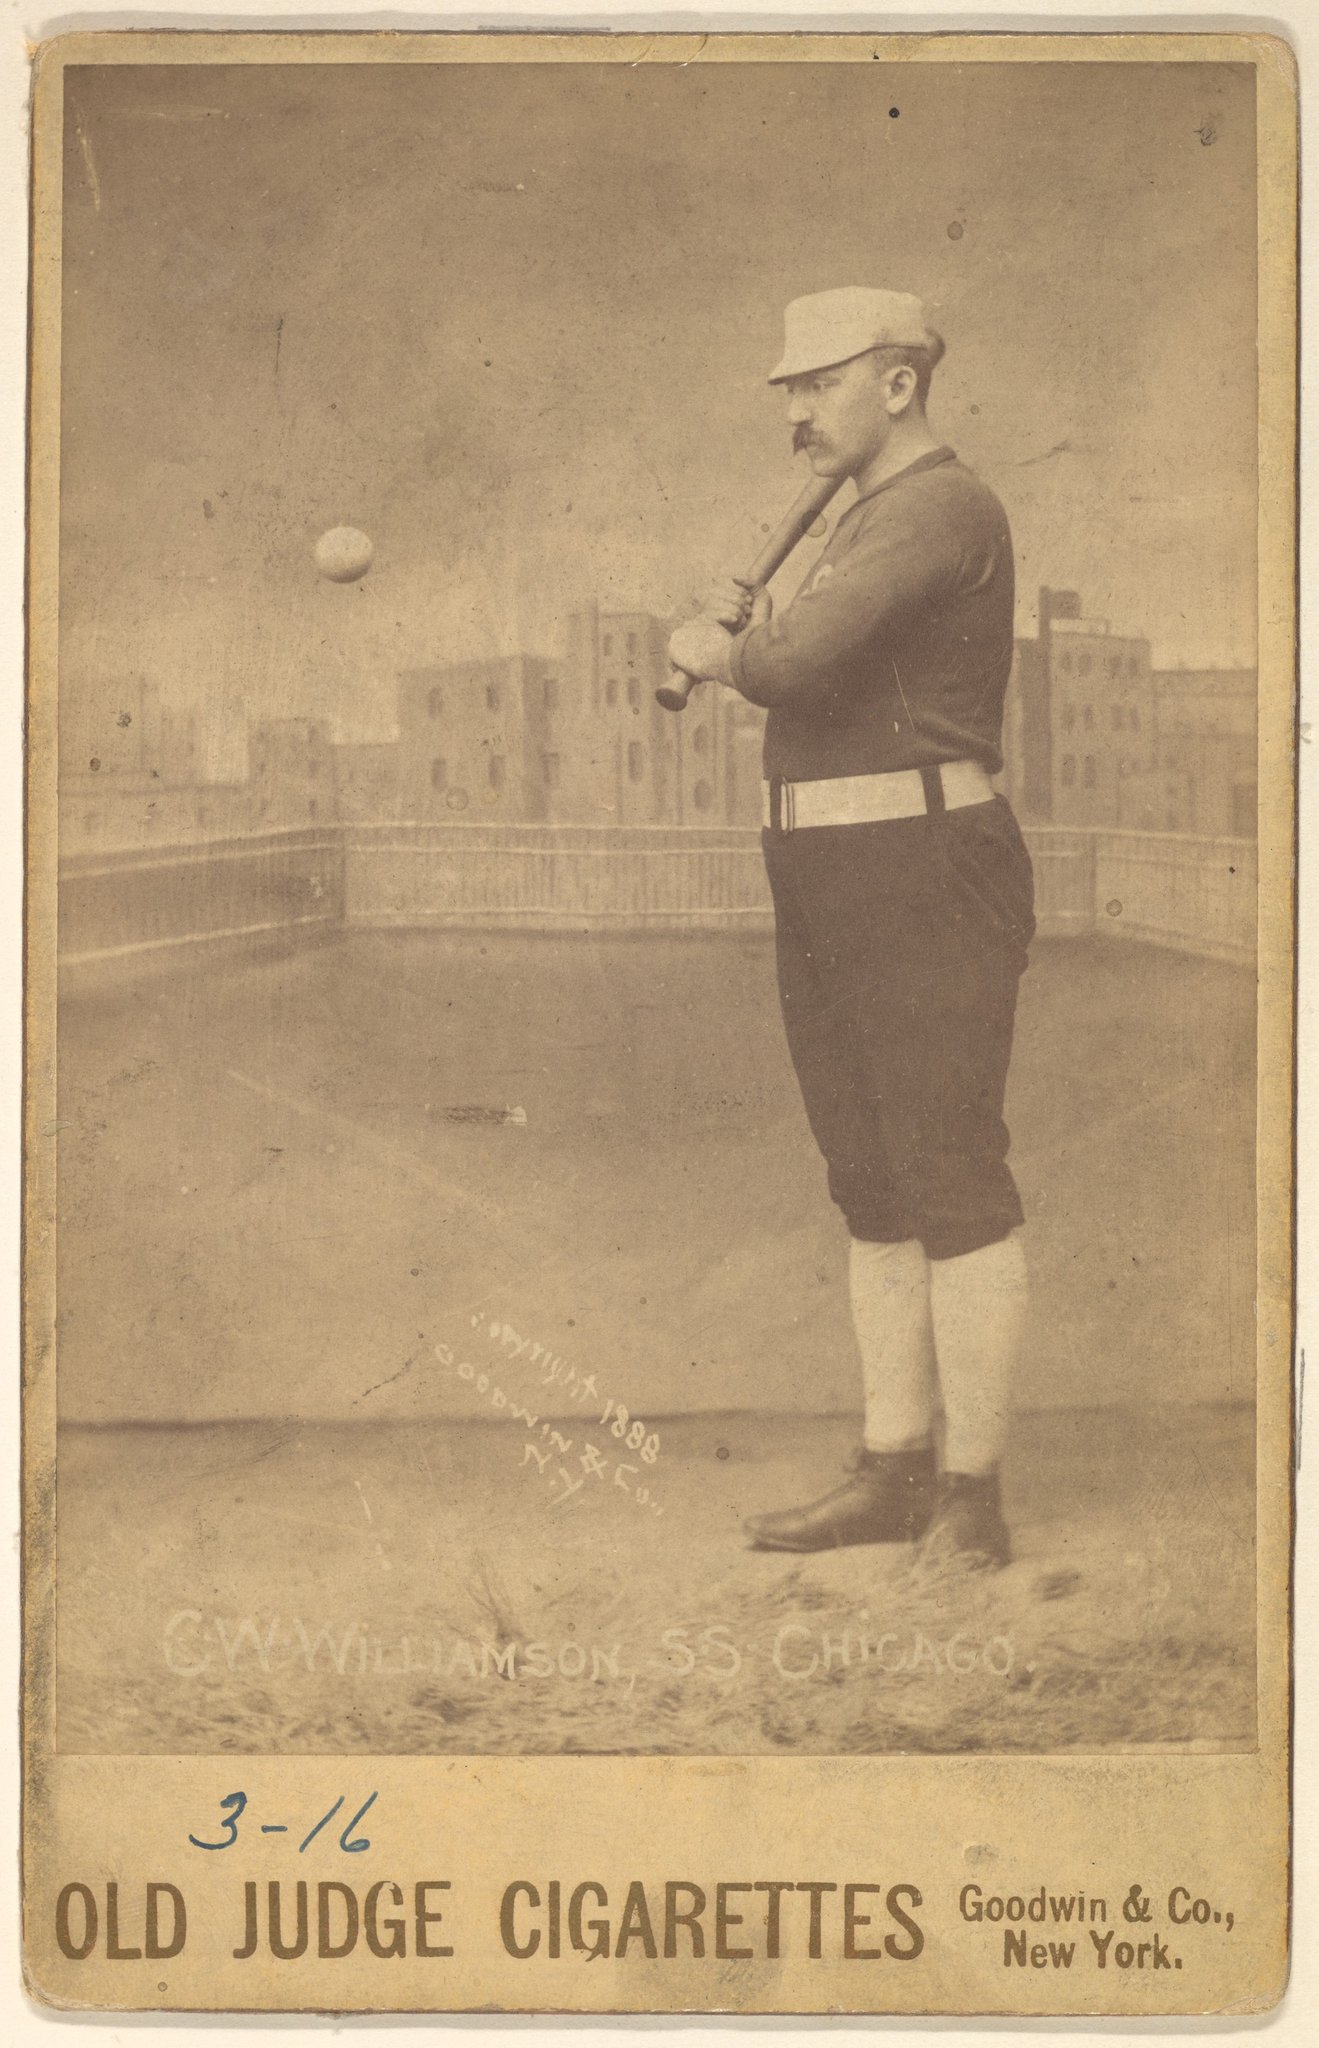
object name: baseball card, photograph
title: C.W. Williamson, Shortstop, Chicago, from the series Old Judge Cigarettes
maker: goodwin & company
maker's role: publisher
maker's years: 1850-1950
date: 1888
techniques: albumen silver print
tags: men,portraits,baseball,athletes